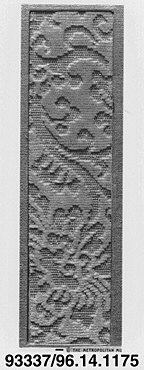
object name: piece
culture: japanese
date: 1701-1900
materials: silk